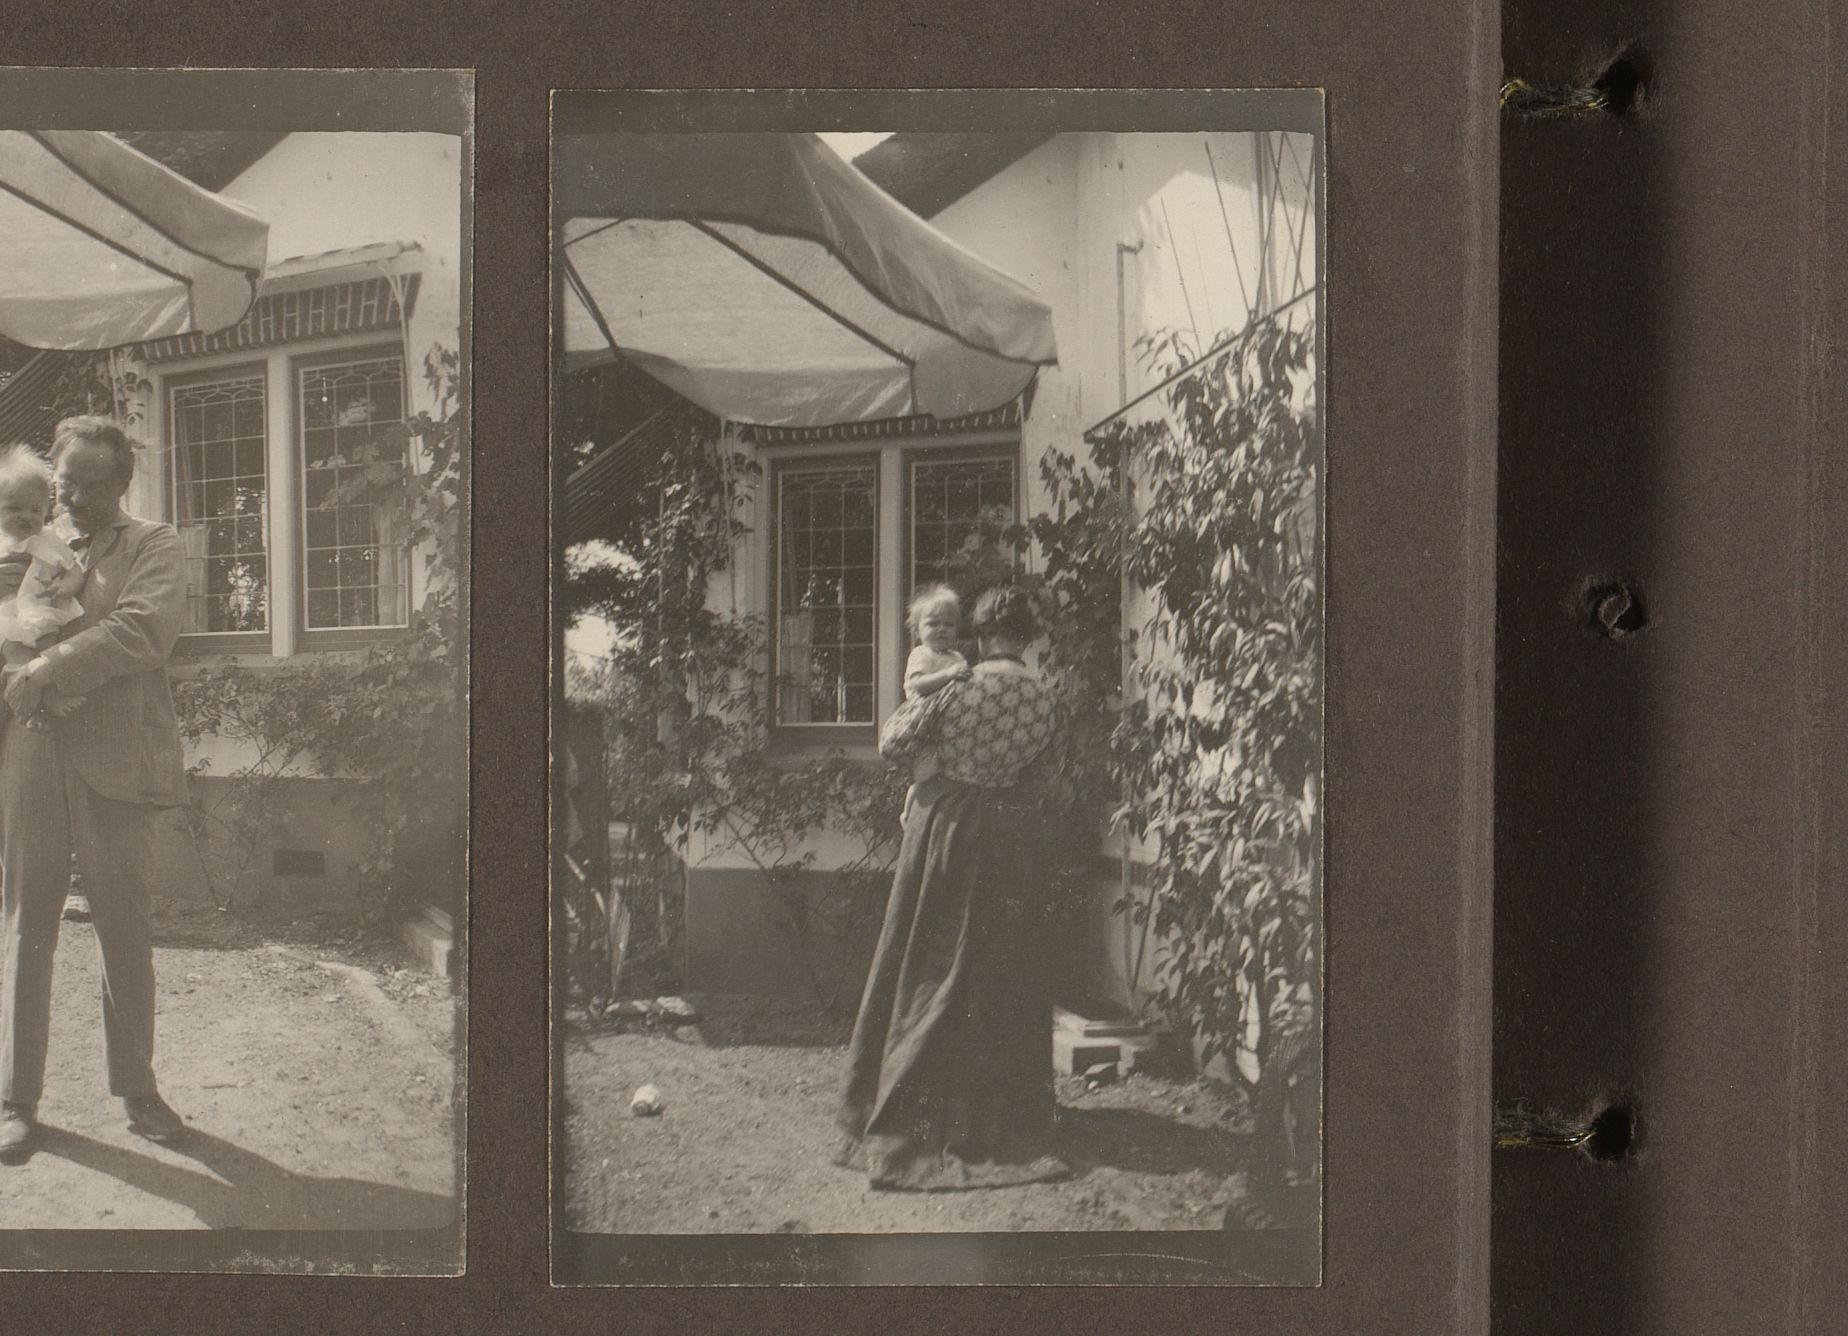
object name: photograph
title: Vrouw met kind op de arm in de tuin van Villa de Hoeve in Laren, vermoedelijk Elsa en Thea Diepenbrock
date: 1905-1910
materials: paper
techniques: gelatin silver print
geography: laren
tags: elsa diepenbrock, amsterdam, mother with daughter(s) (mother-love), historical persons - bb - woman, villa, backyard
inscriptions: inscription: ‘"De Hoeve"’